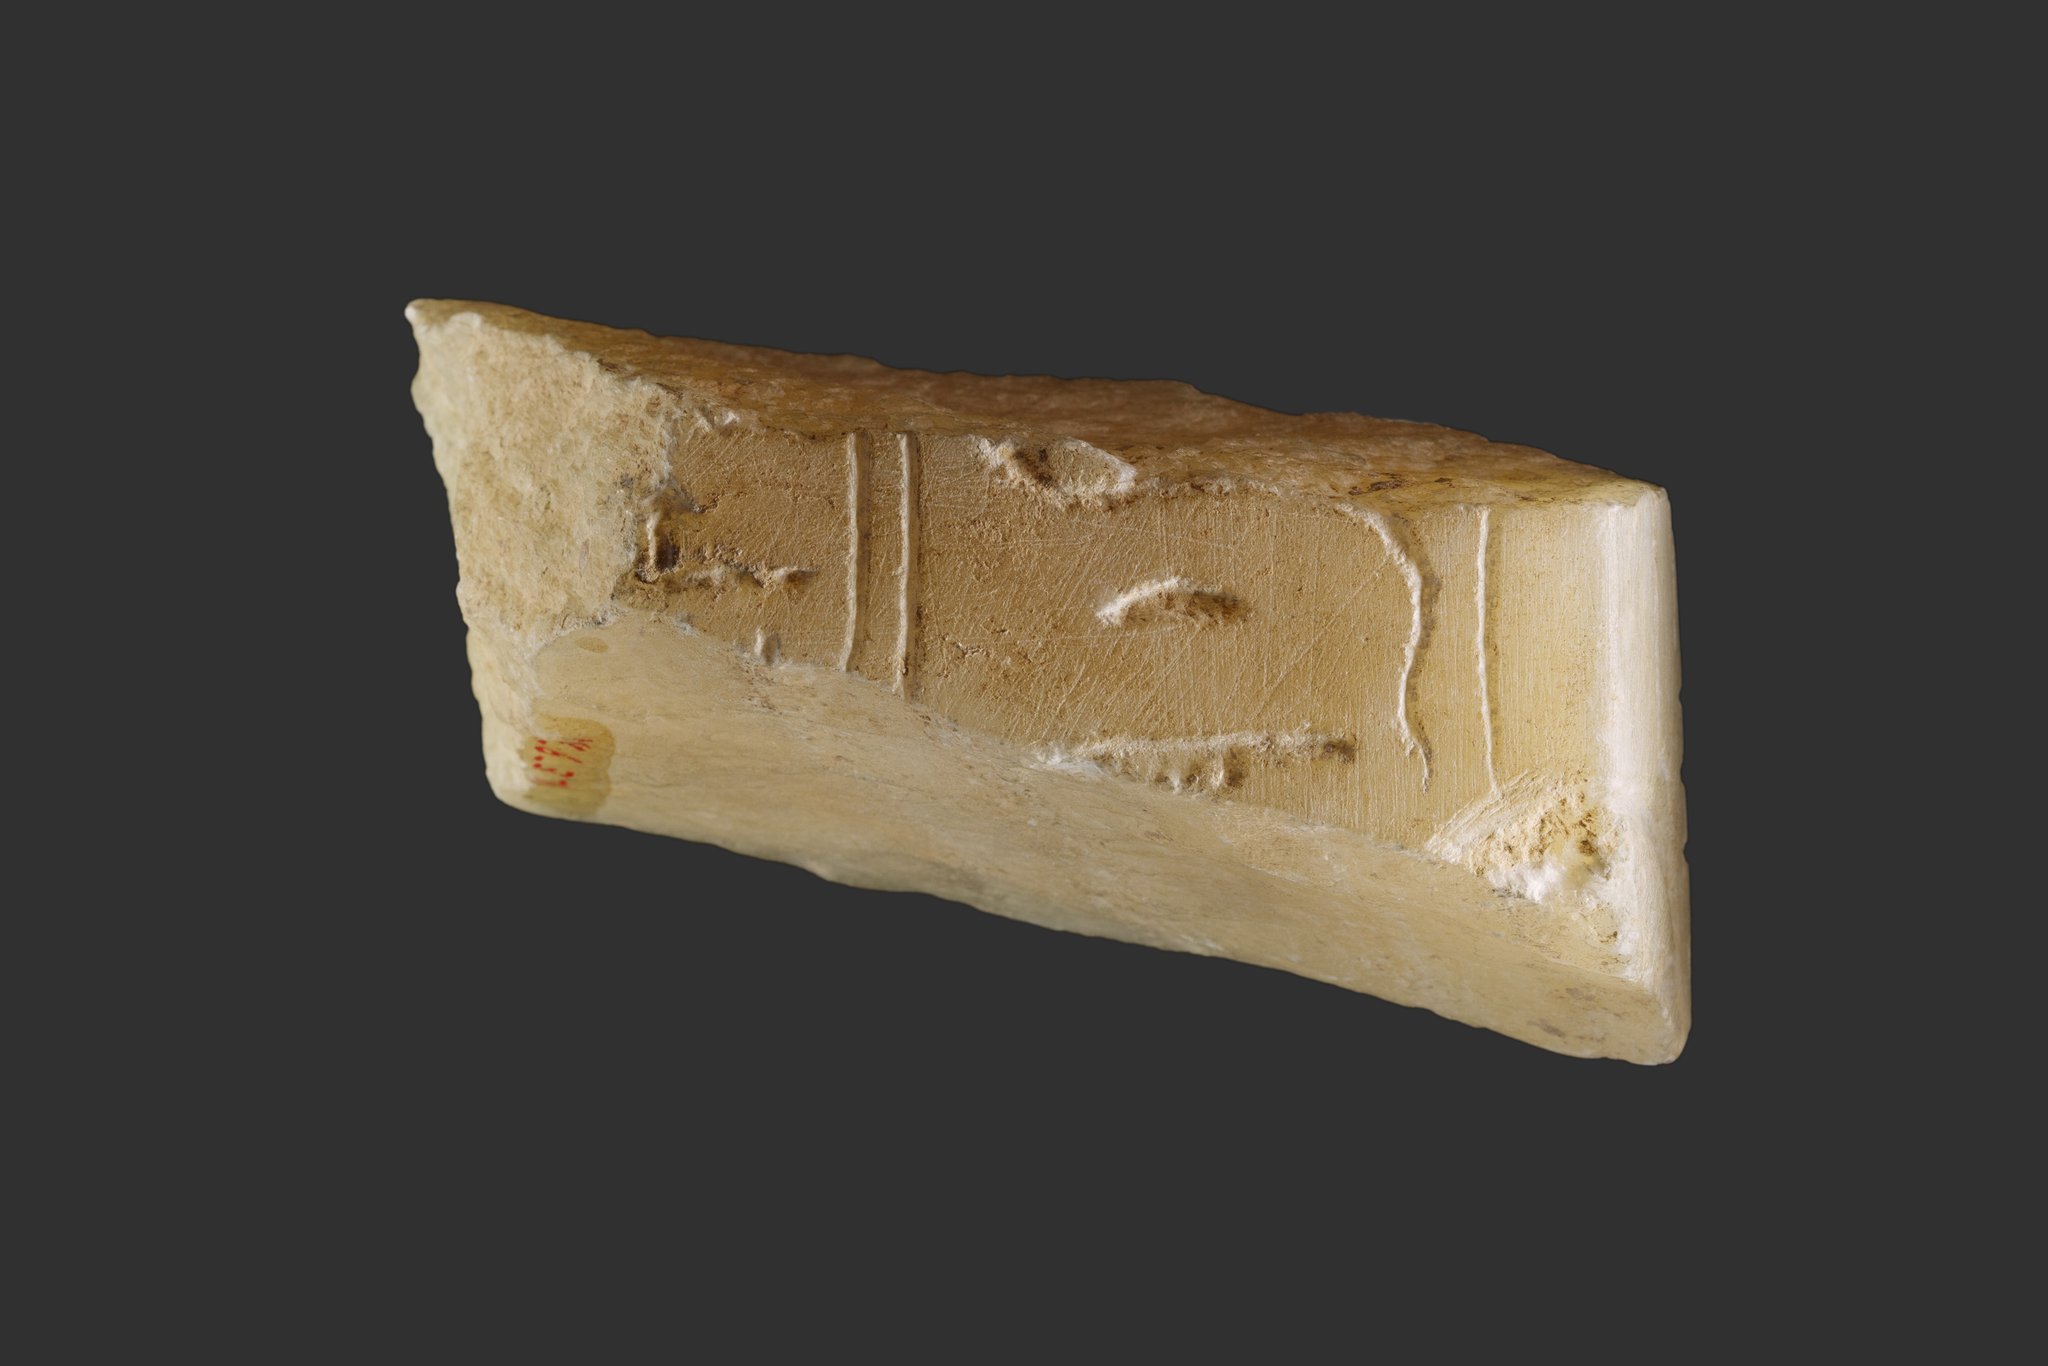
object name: canopic chest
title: Canopic Chest Fragment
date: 1194-1188 BCE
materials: stone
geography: egypt